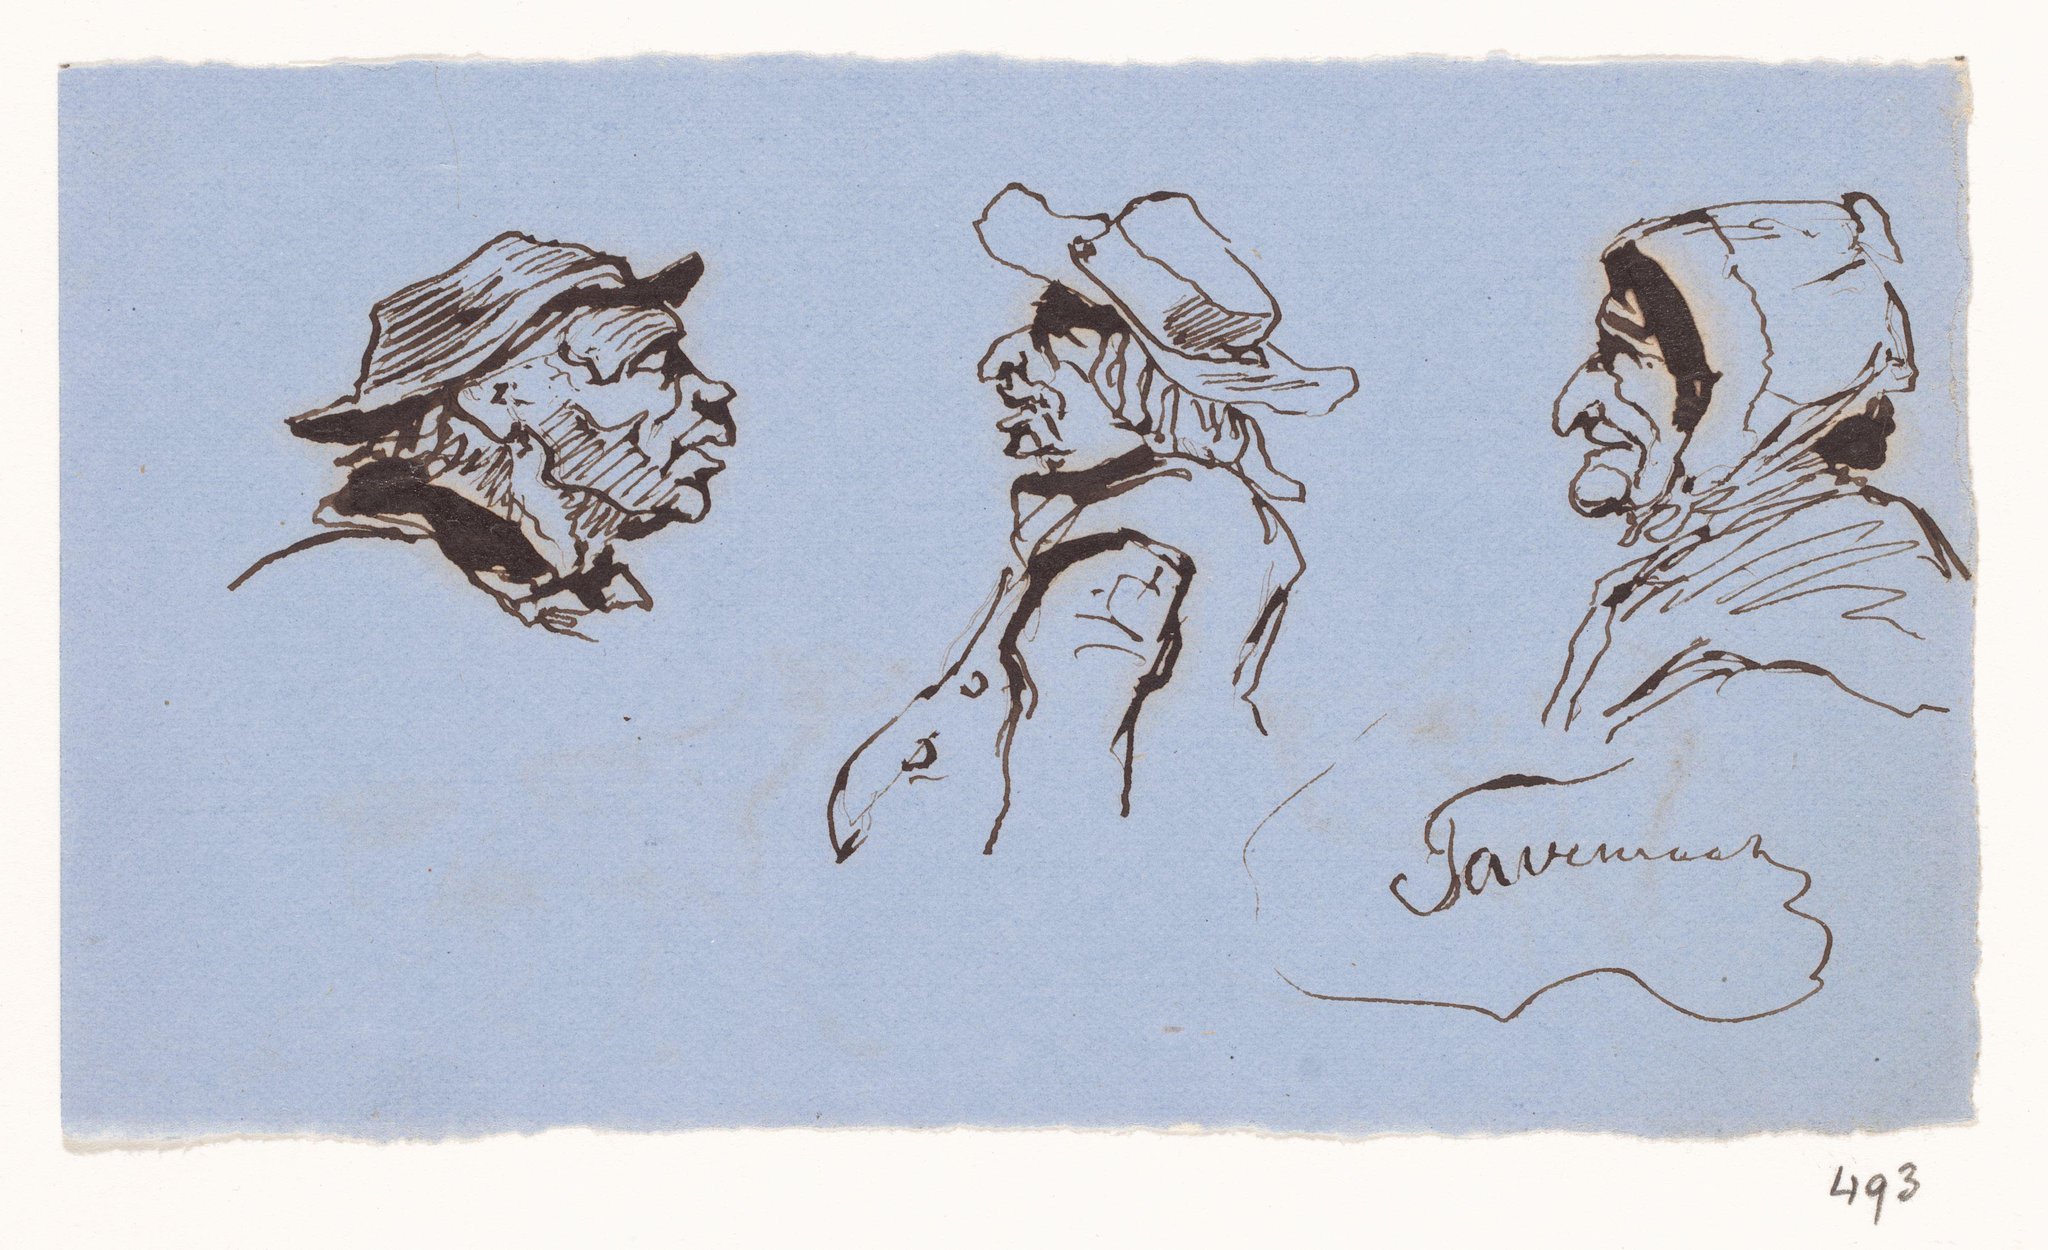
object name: drawing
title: Drie koppen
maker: johannes tavenraat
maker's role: draughtsman, painter, print maker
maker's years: 1809-1881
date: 1840-1880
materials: ink, paper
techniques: pen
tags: caricatures (human types)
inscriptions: signature: ‘Tavenraat’